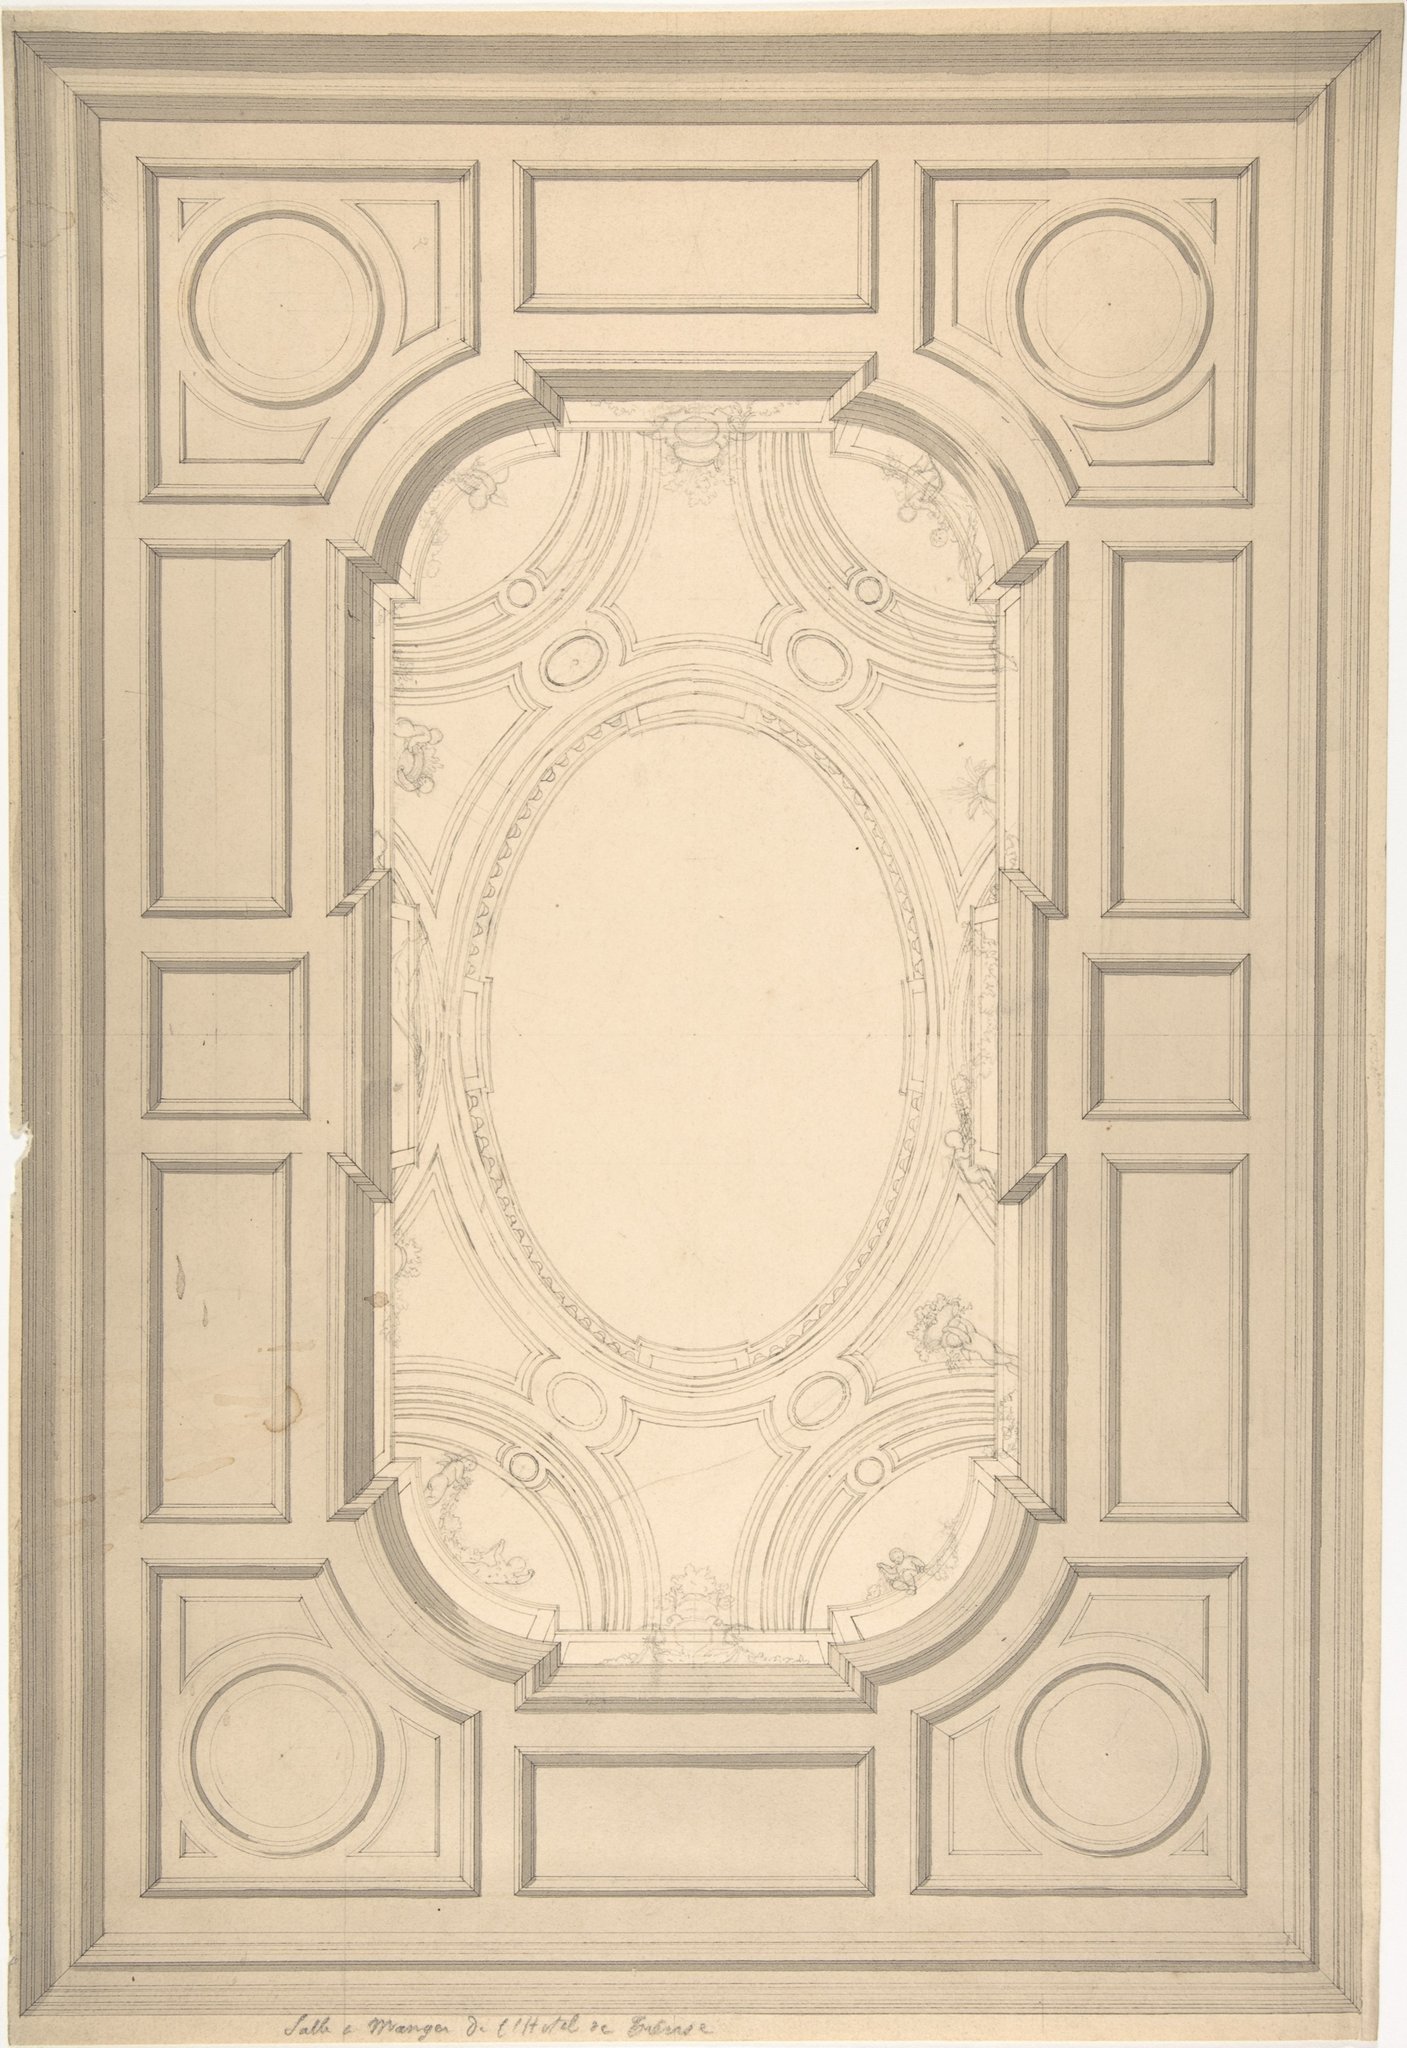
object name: drawing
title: Design for Trompe L'Oeil Ceiling for Dining Room, Hôtel de Trévise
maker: jules-edmond-charles lachaise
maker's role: artist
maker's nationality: french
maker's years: 1897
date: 1850-1910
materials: ink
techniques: brush, pen, wash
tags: ceilings